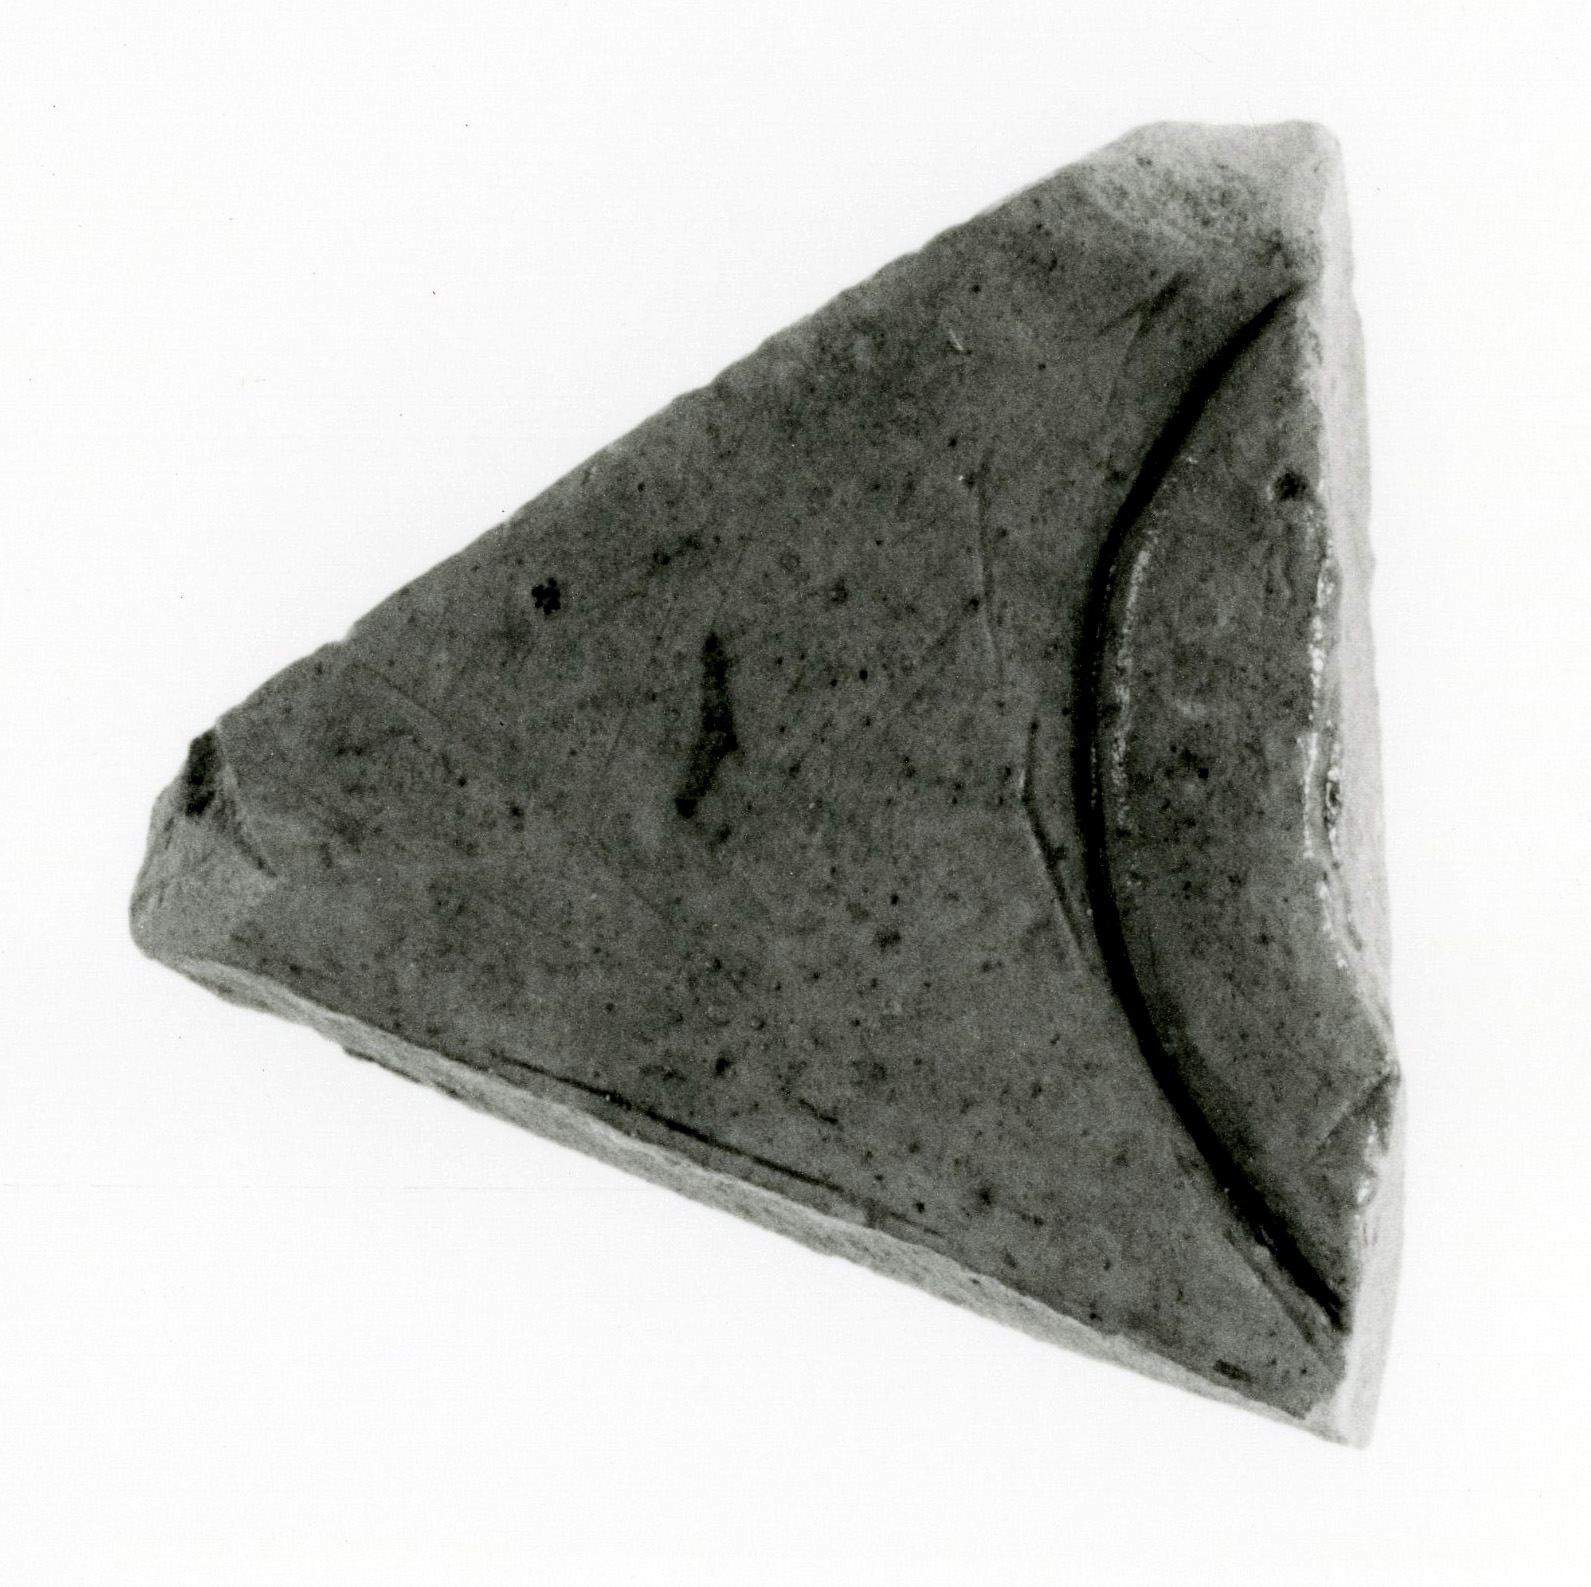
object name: relief, tomb of nespekashuty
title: Raised relief fragment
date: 664-610 BCE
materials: limestone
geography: egypt